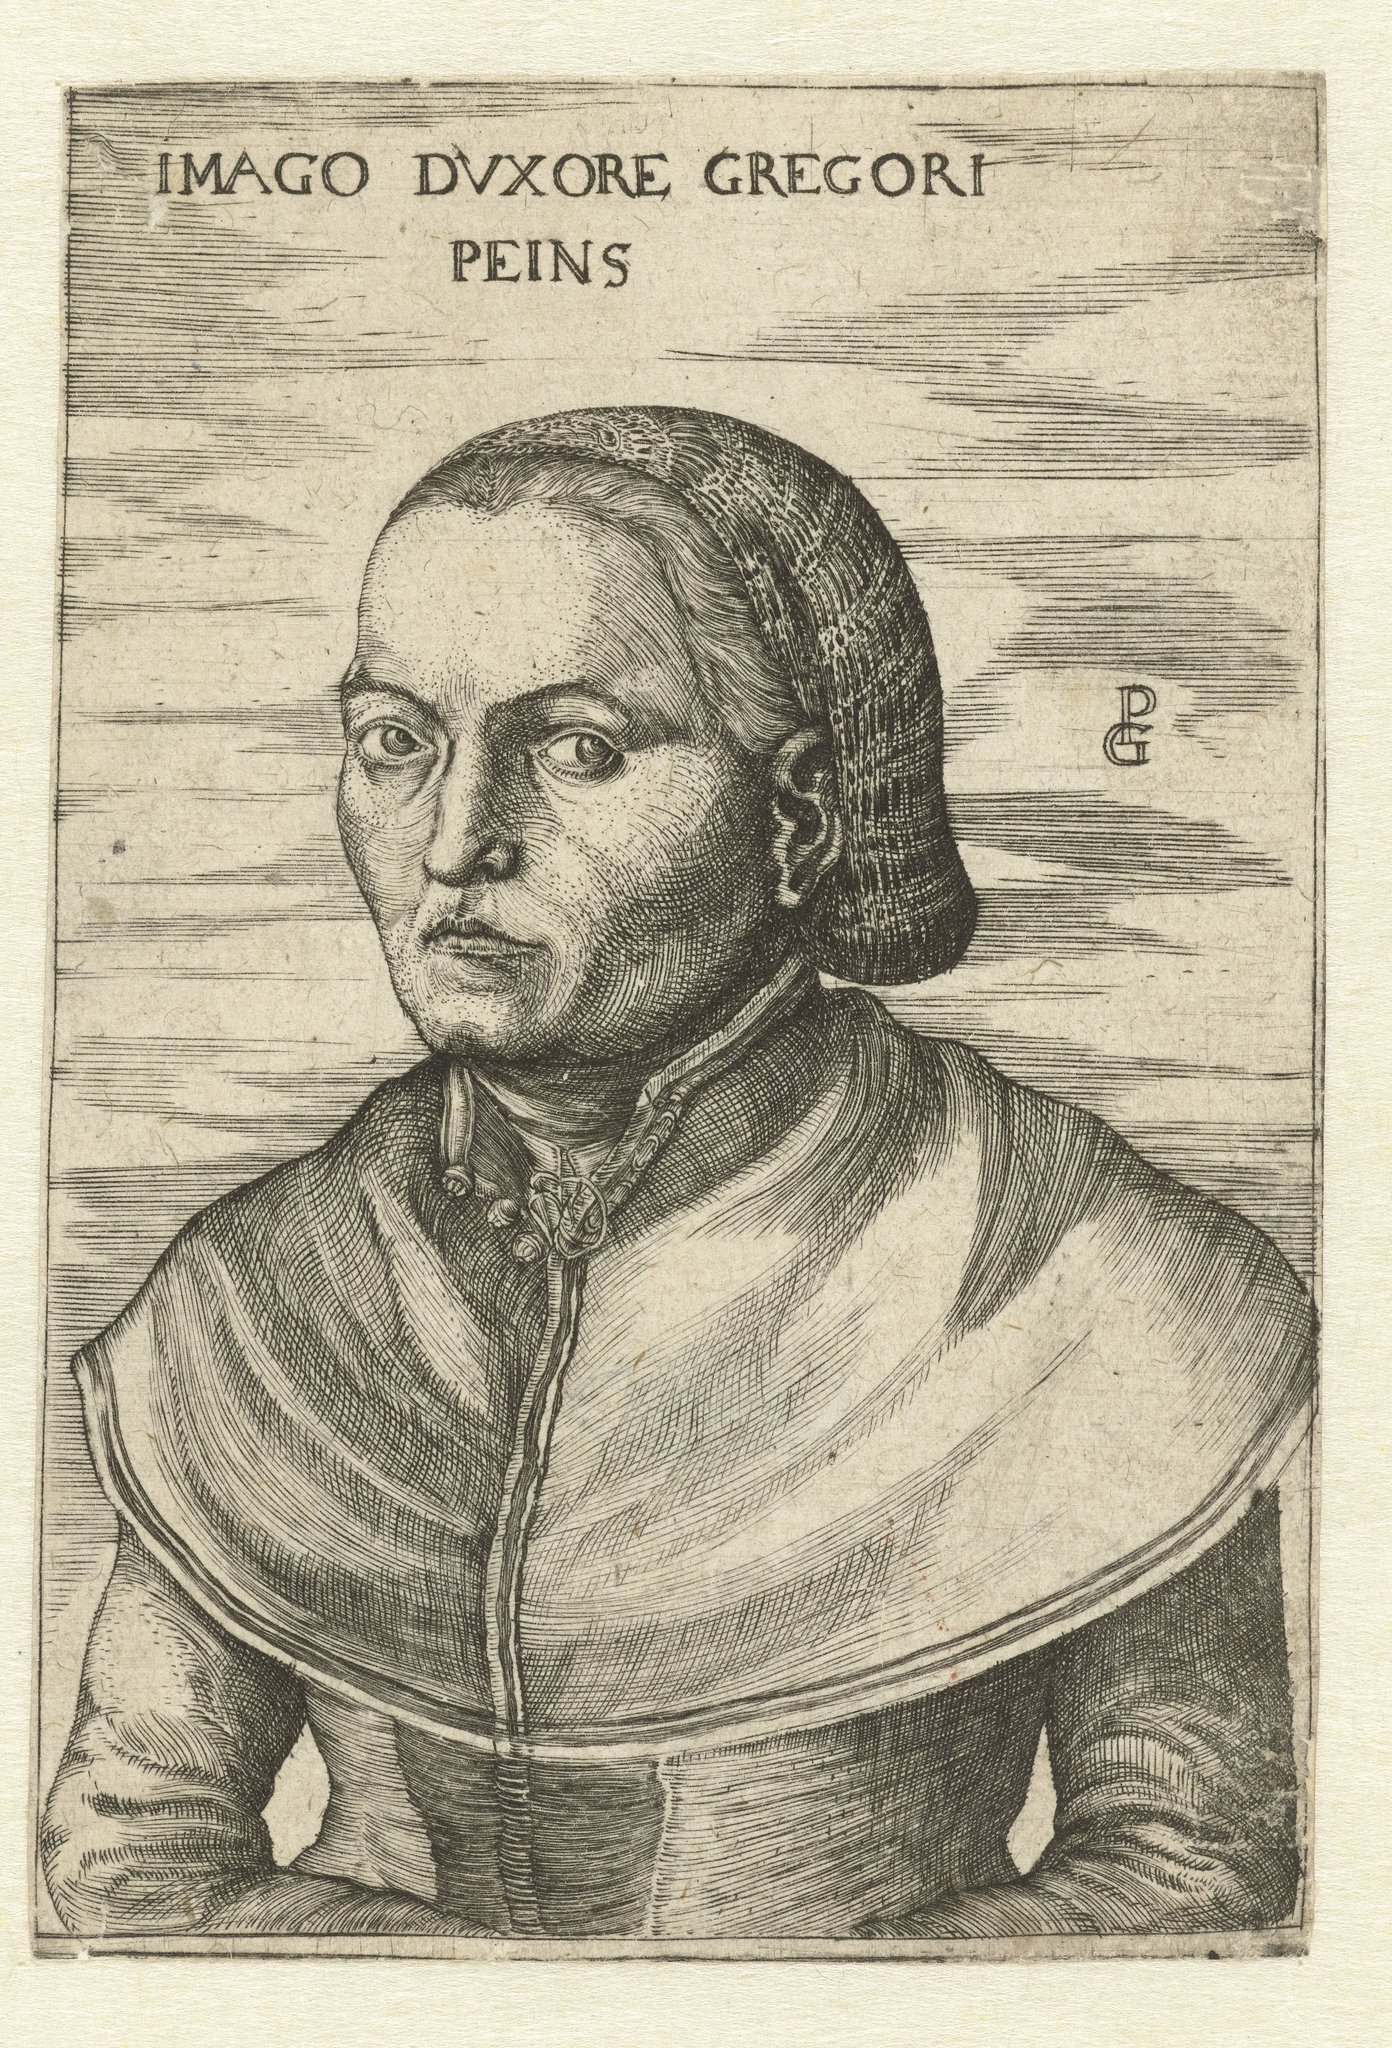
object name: print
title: Portret van de vrouw van Georg Pencz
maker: Anonymous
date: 1510-1599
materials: paper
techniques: engraving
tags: george pencz (vrouw van)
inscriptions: collector's mark: Lugt 240, collector's mark: Lugt 2228a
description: Portret van de vrouw van graveur en schilder Georg Pencz. Dit portret maakt deel uit van een dubbelportret waarop ook de kunstenaar staat afgebeeld. Hun beeltenissen waren samen in een plaat gegraveerd maar werden later ook als twee losse prenten afgedrukt zoals in dit geval.